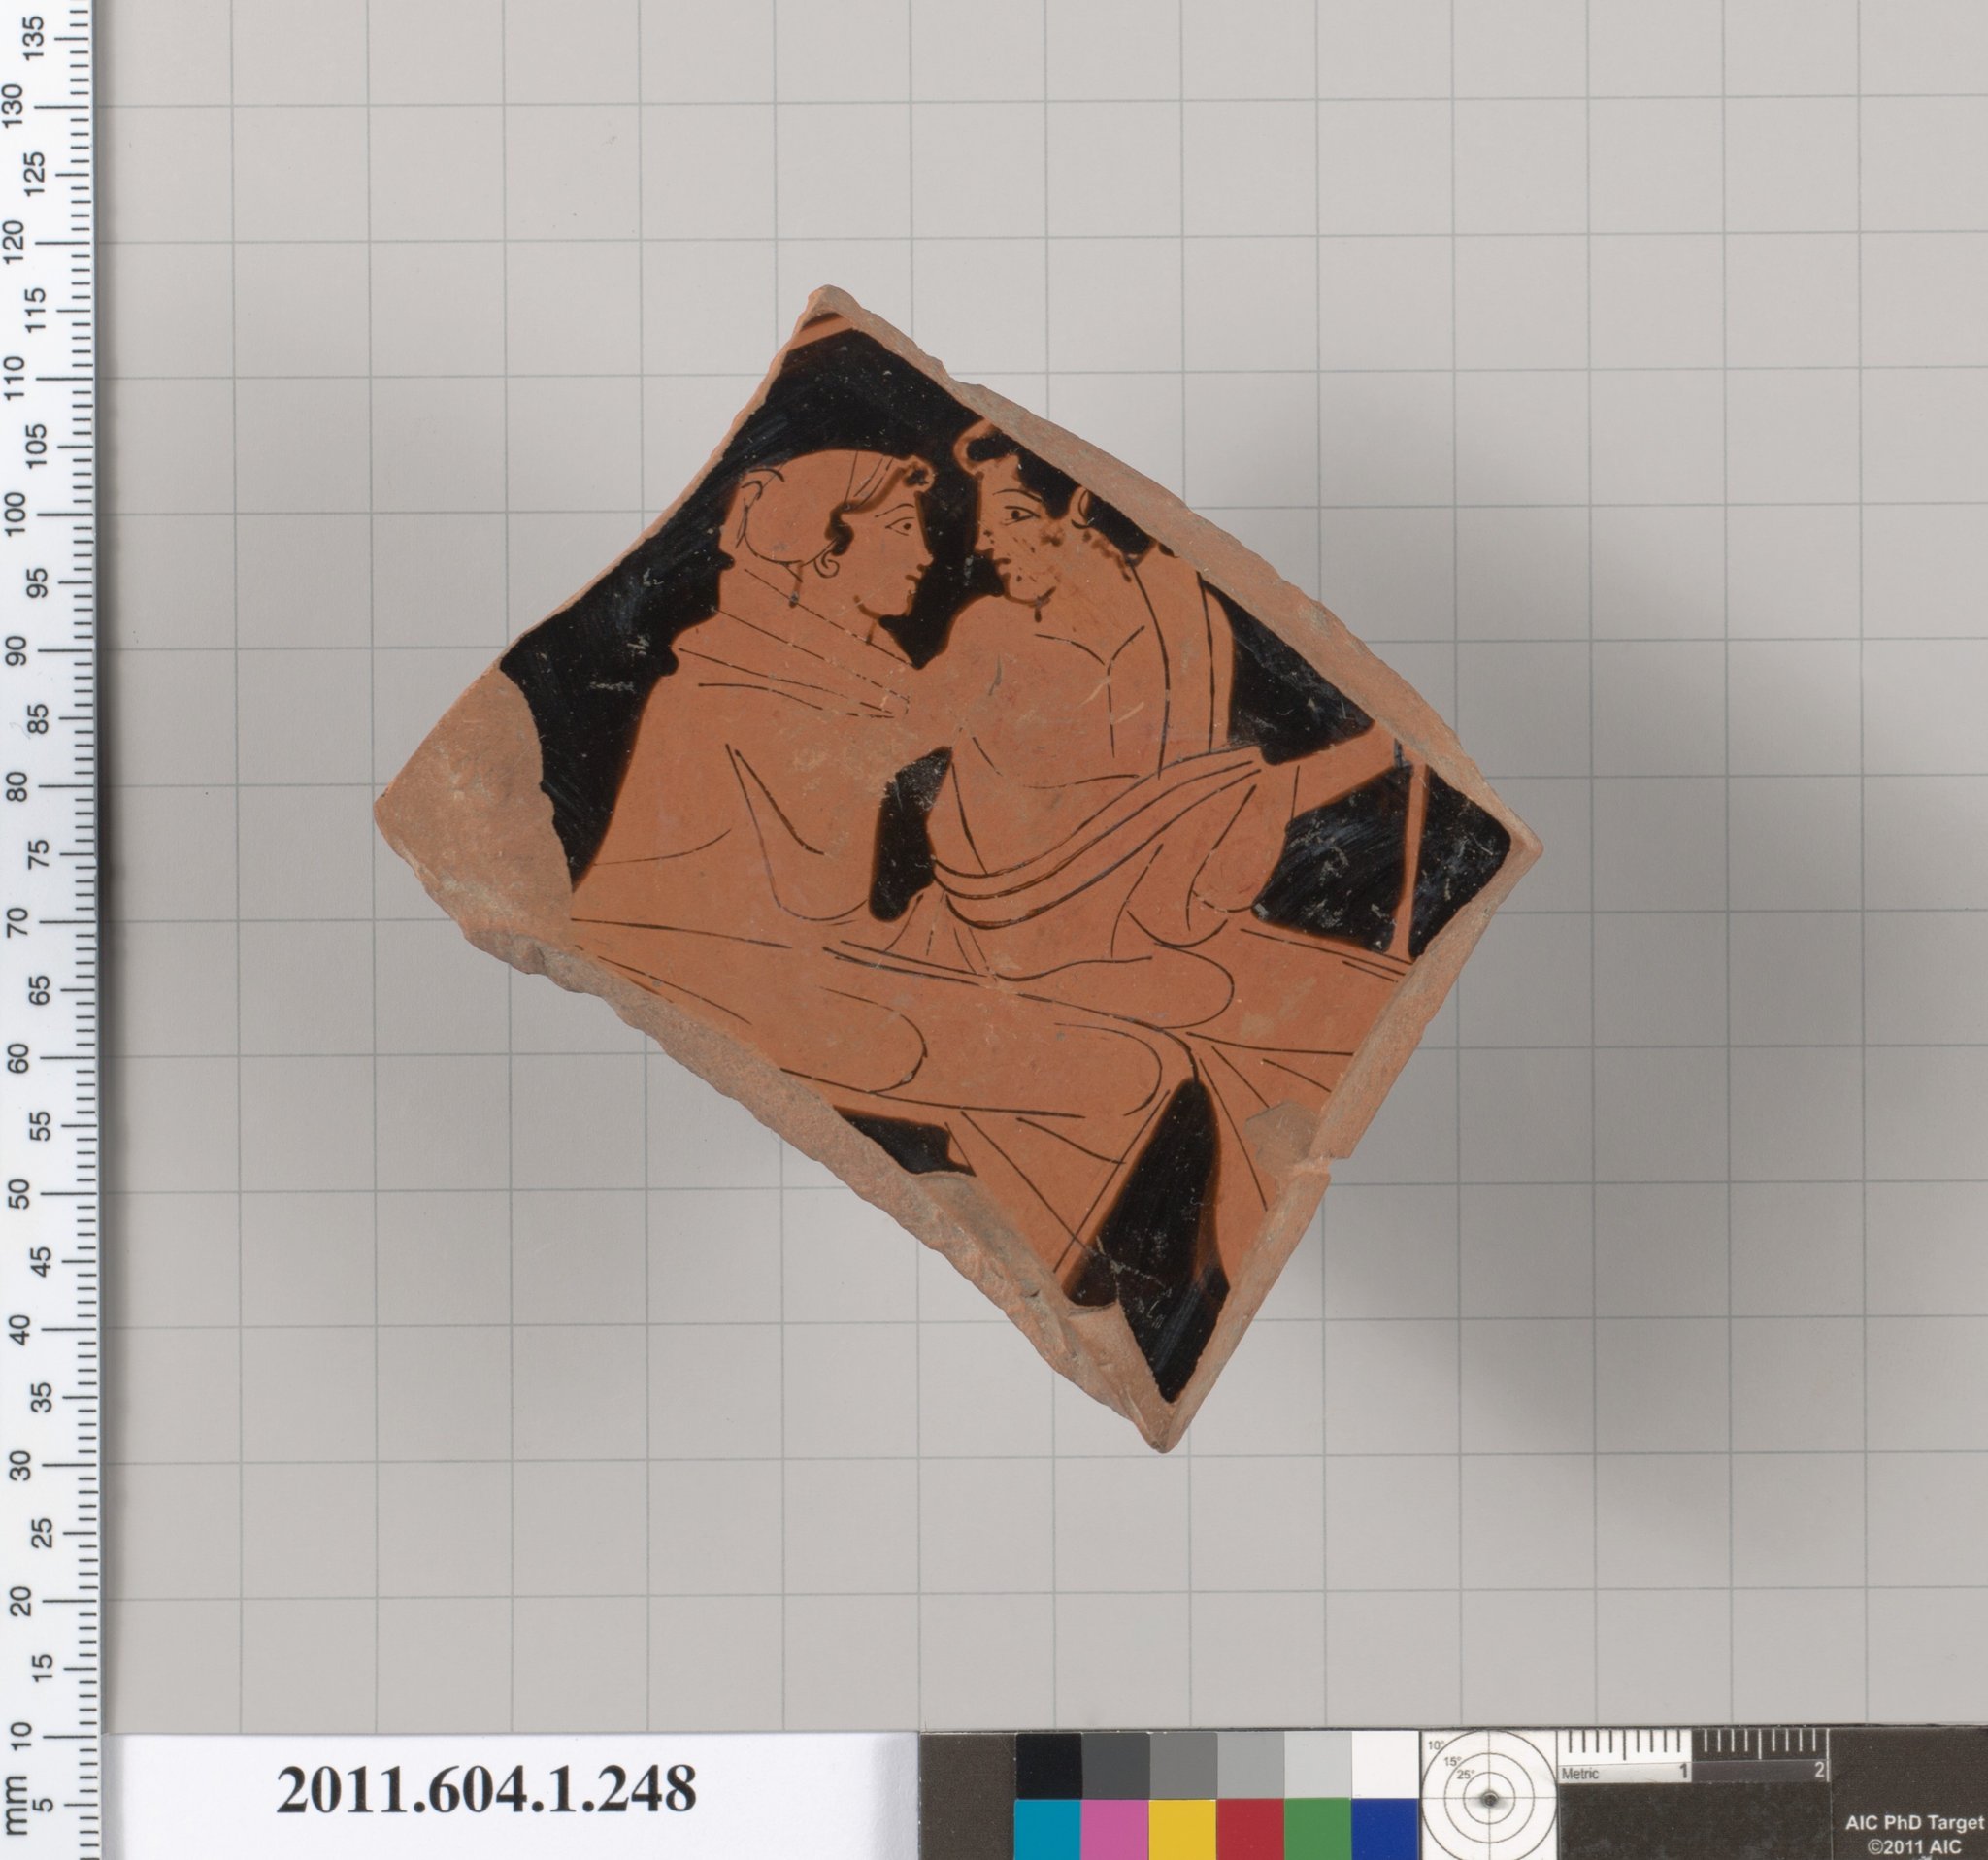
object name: kylix fragment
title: Terracotta fragment of a kylix (drinking cup)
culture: greek, attic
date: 475-451 BCE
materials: terracotta